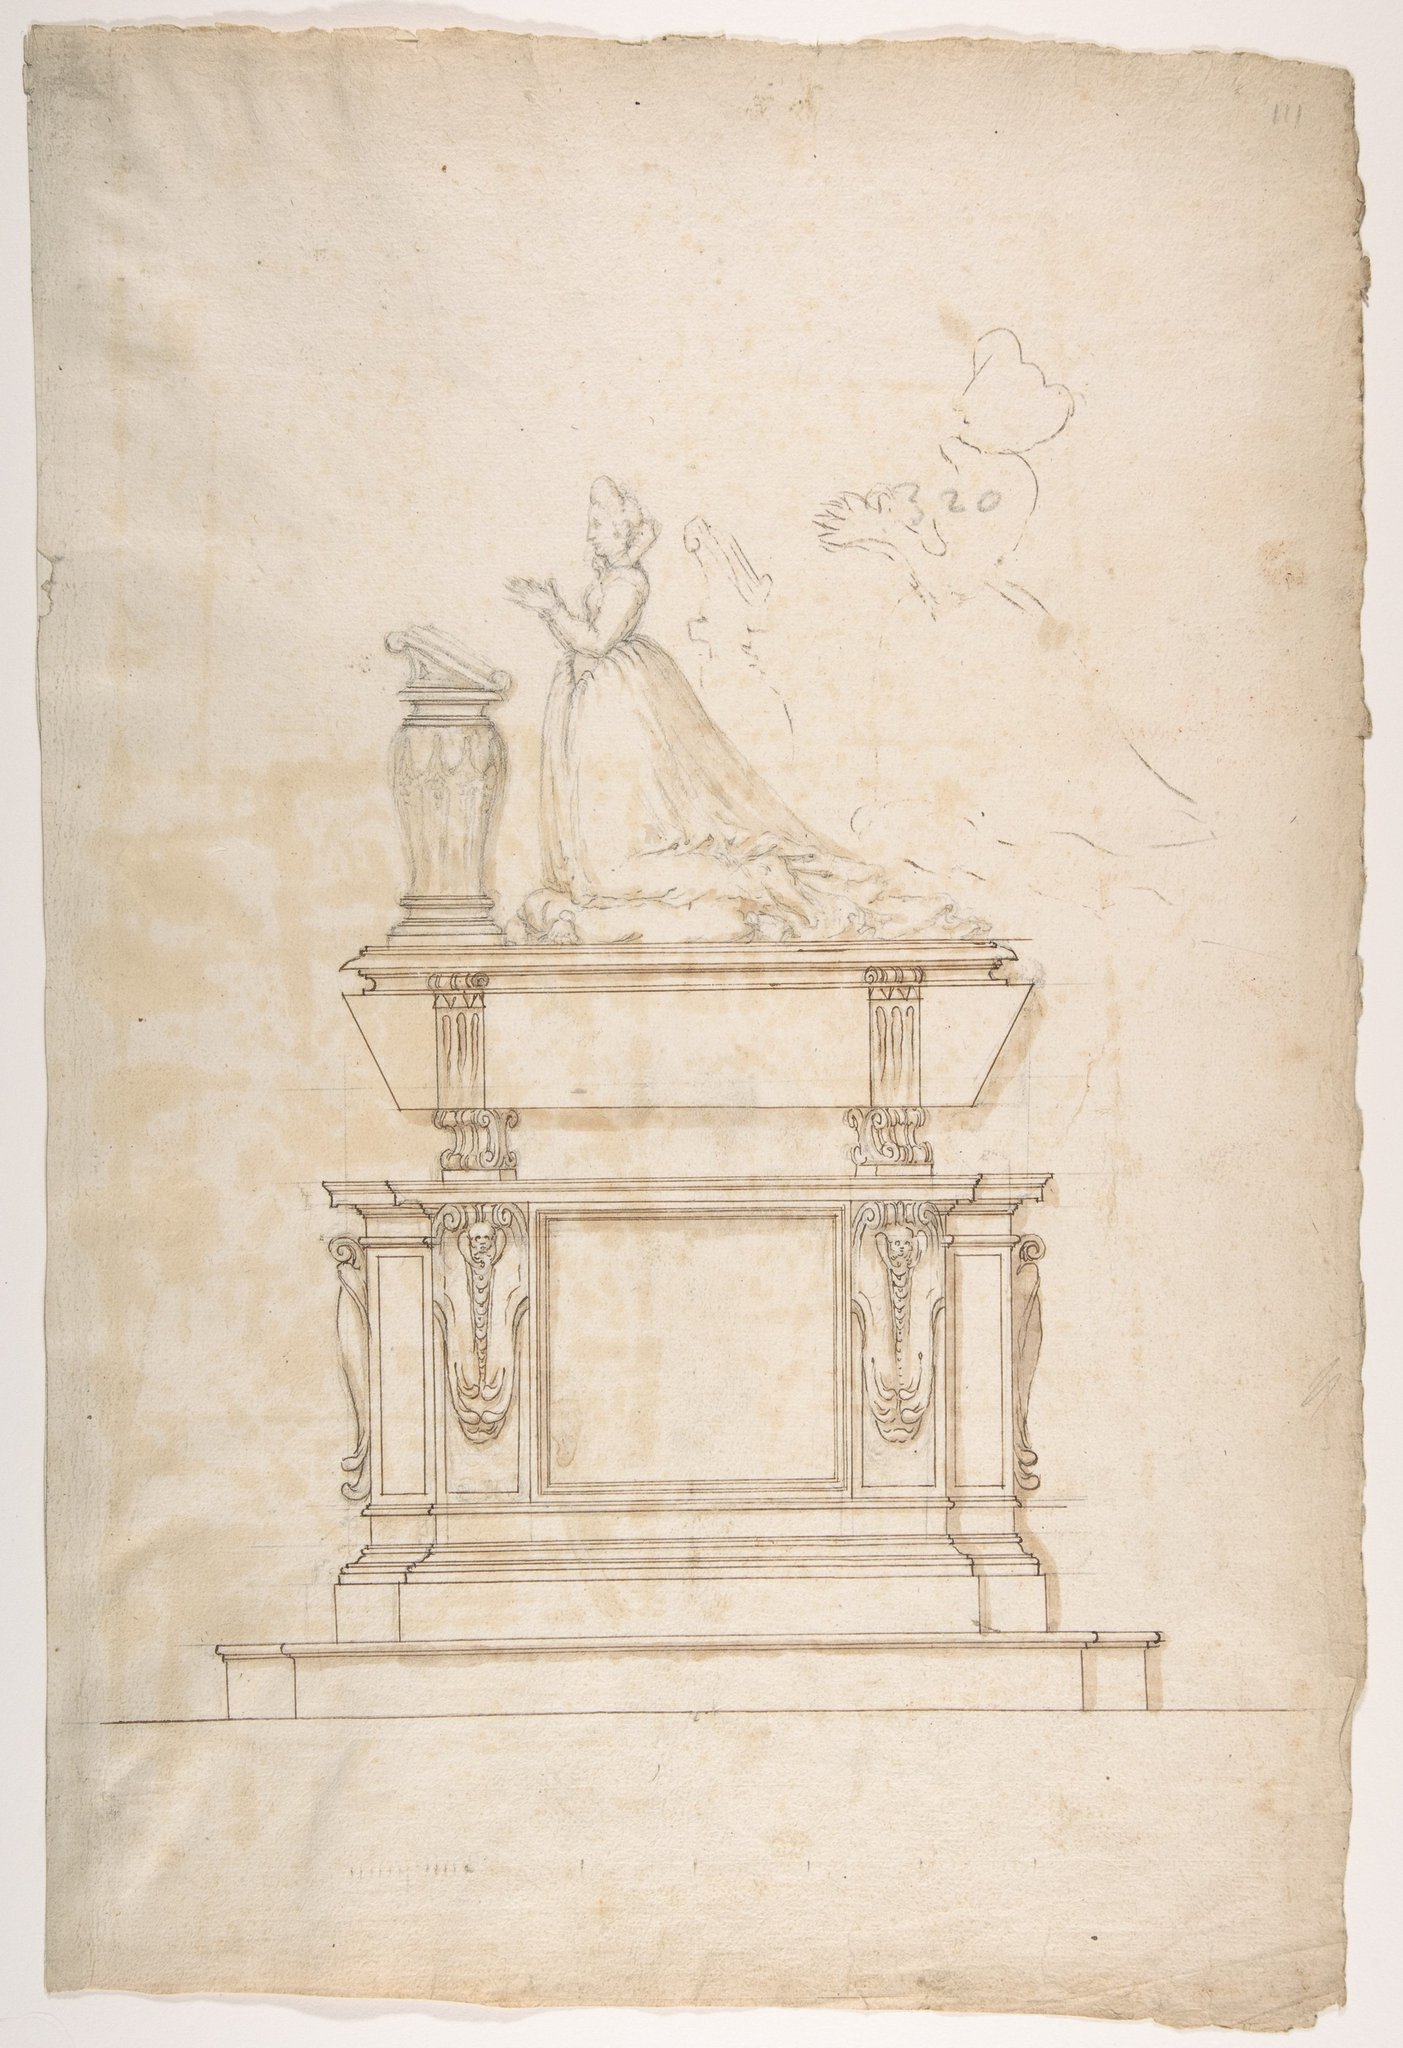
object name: drawing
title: Design for a Lady's Tomb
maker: anonymous, french, 16th century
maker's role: artist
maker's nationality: french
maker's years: 1500-1600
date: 1501-1600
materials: chalk, ink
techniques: brush, pen, wash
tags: tombs,women